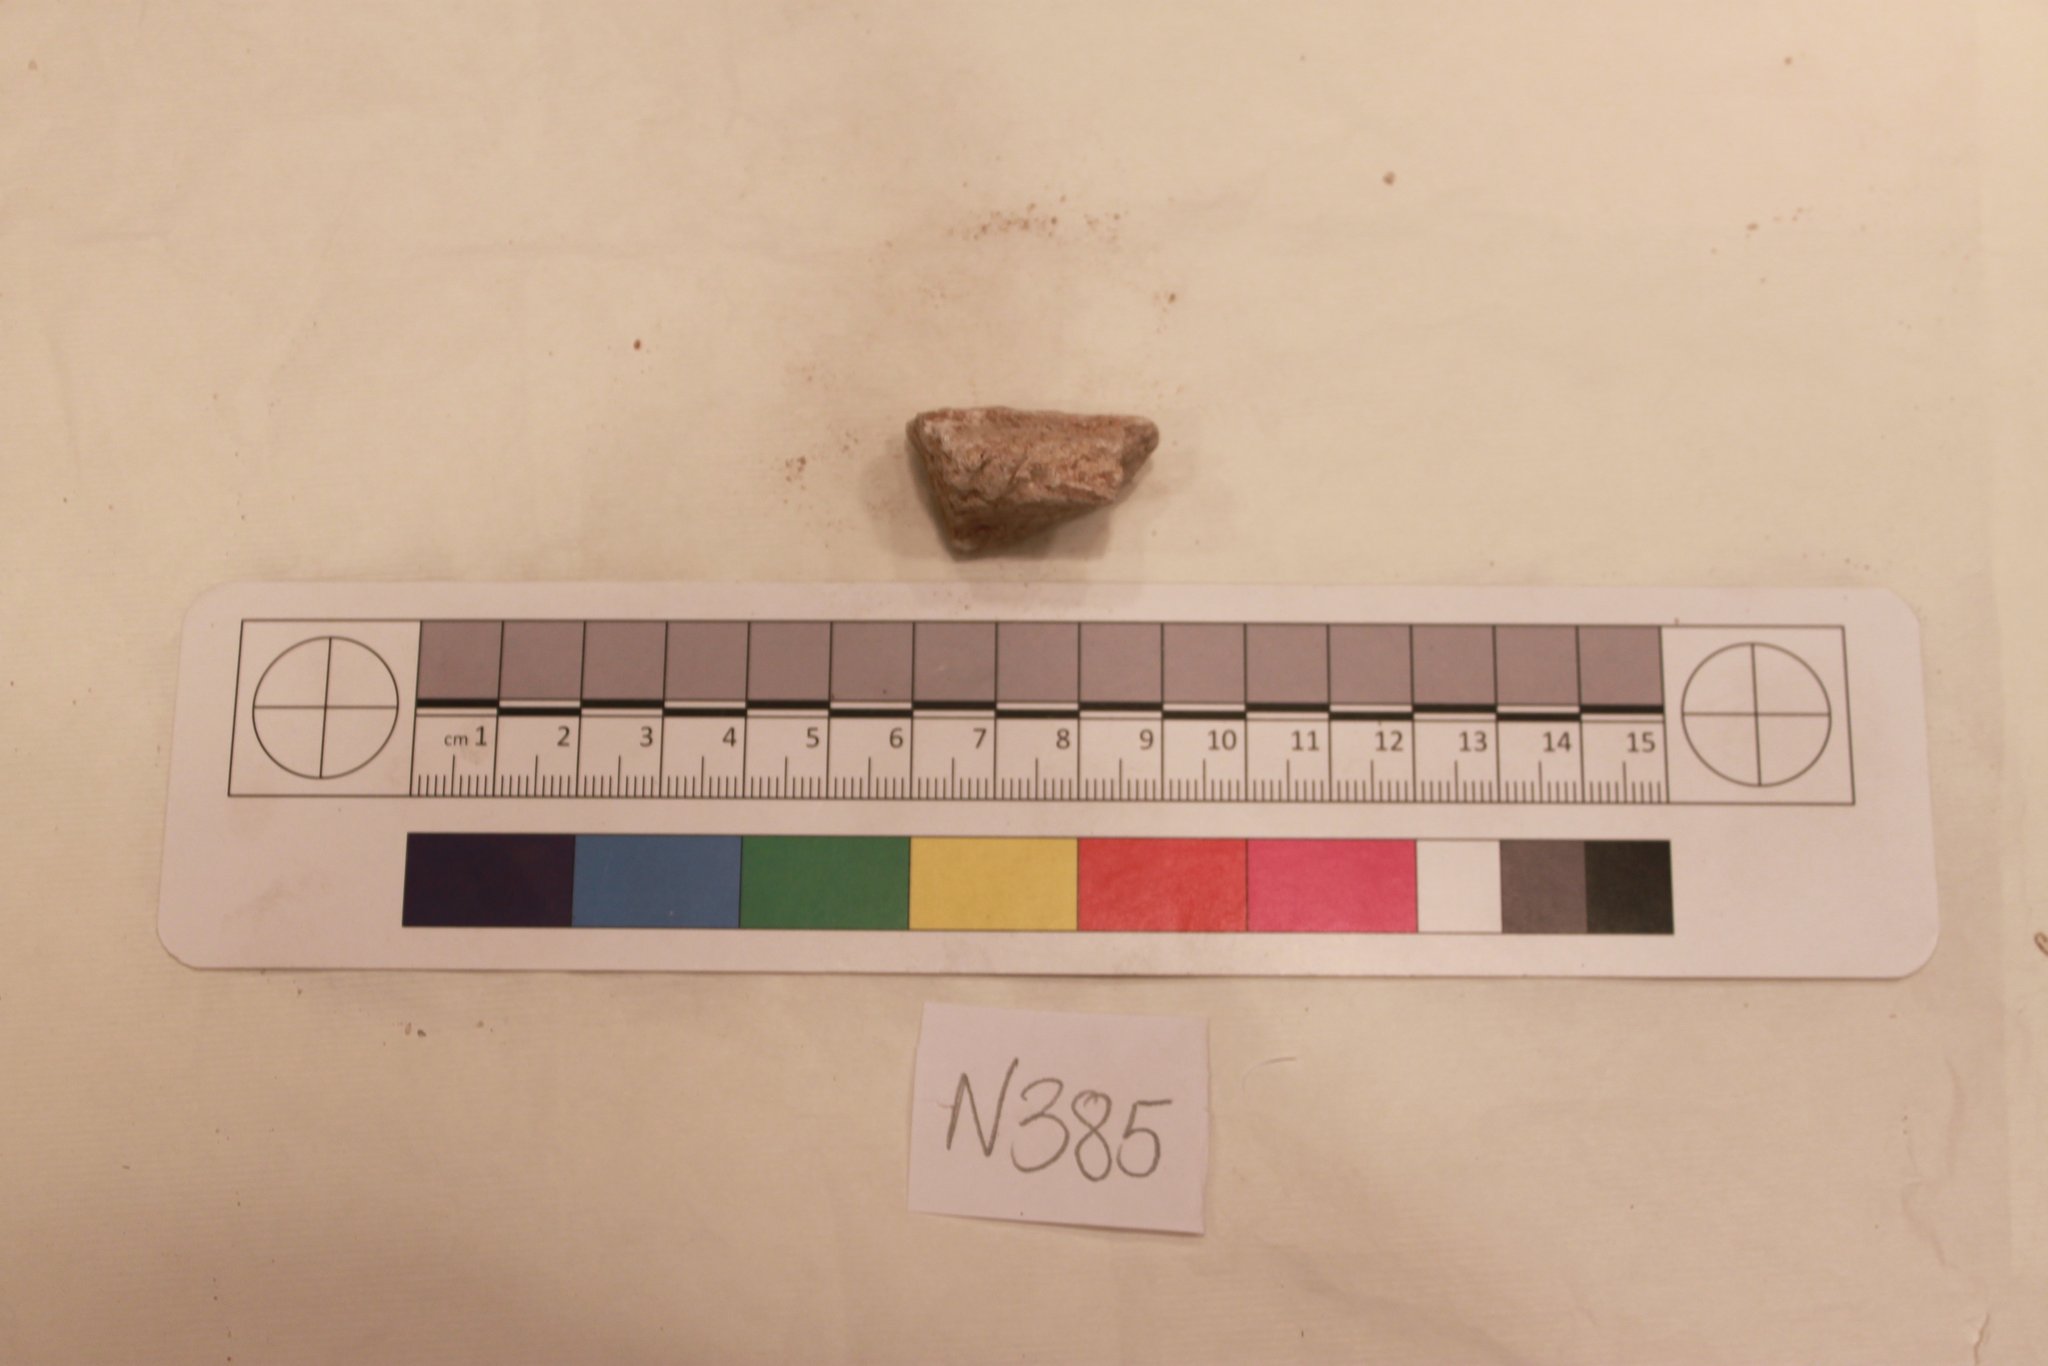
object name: fragment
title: Stucco Fragment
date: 701-1200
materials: plaster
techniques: carving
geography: iran